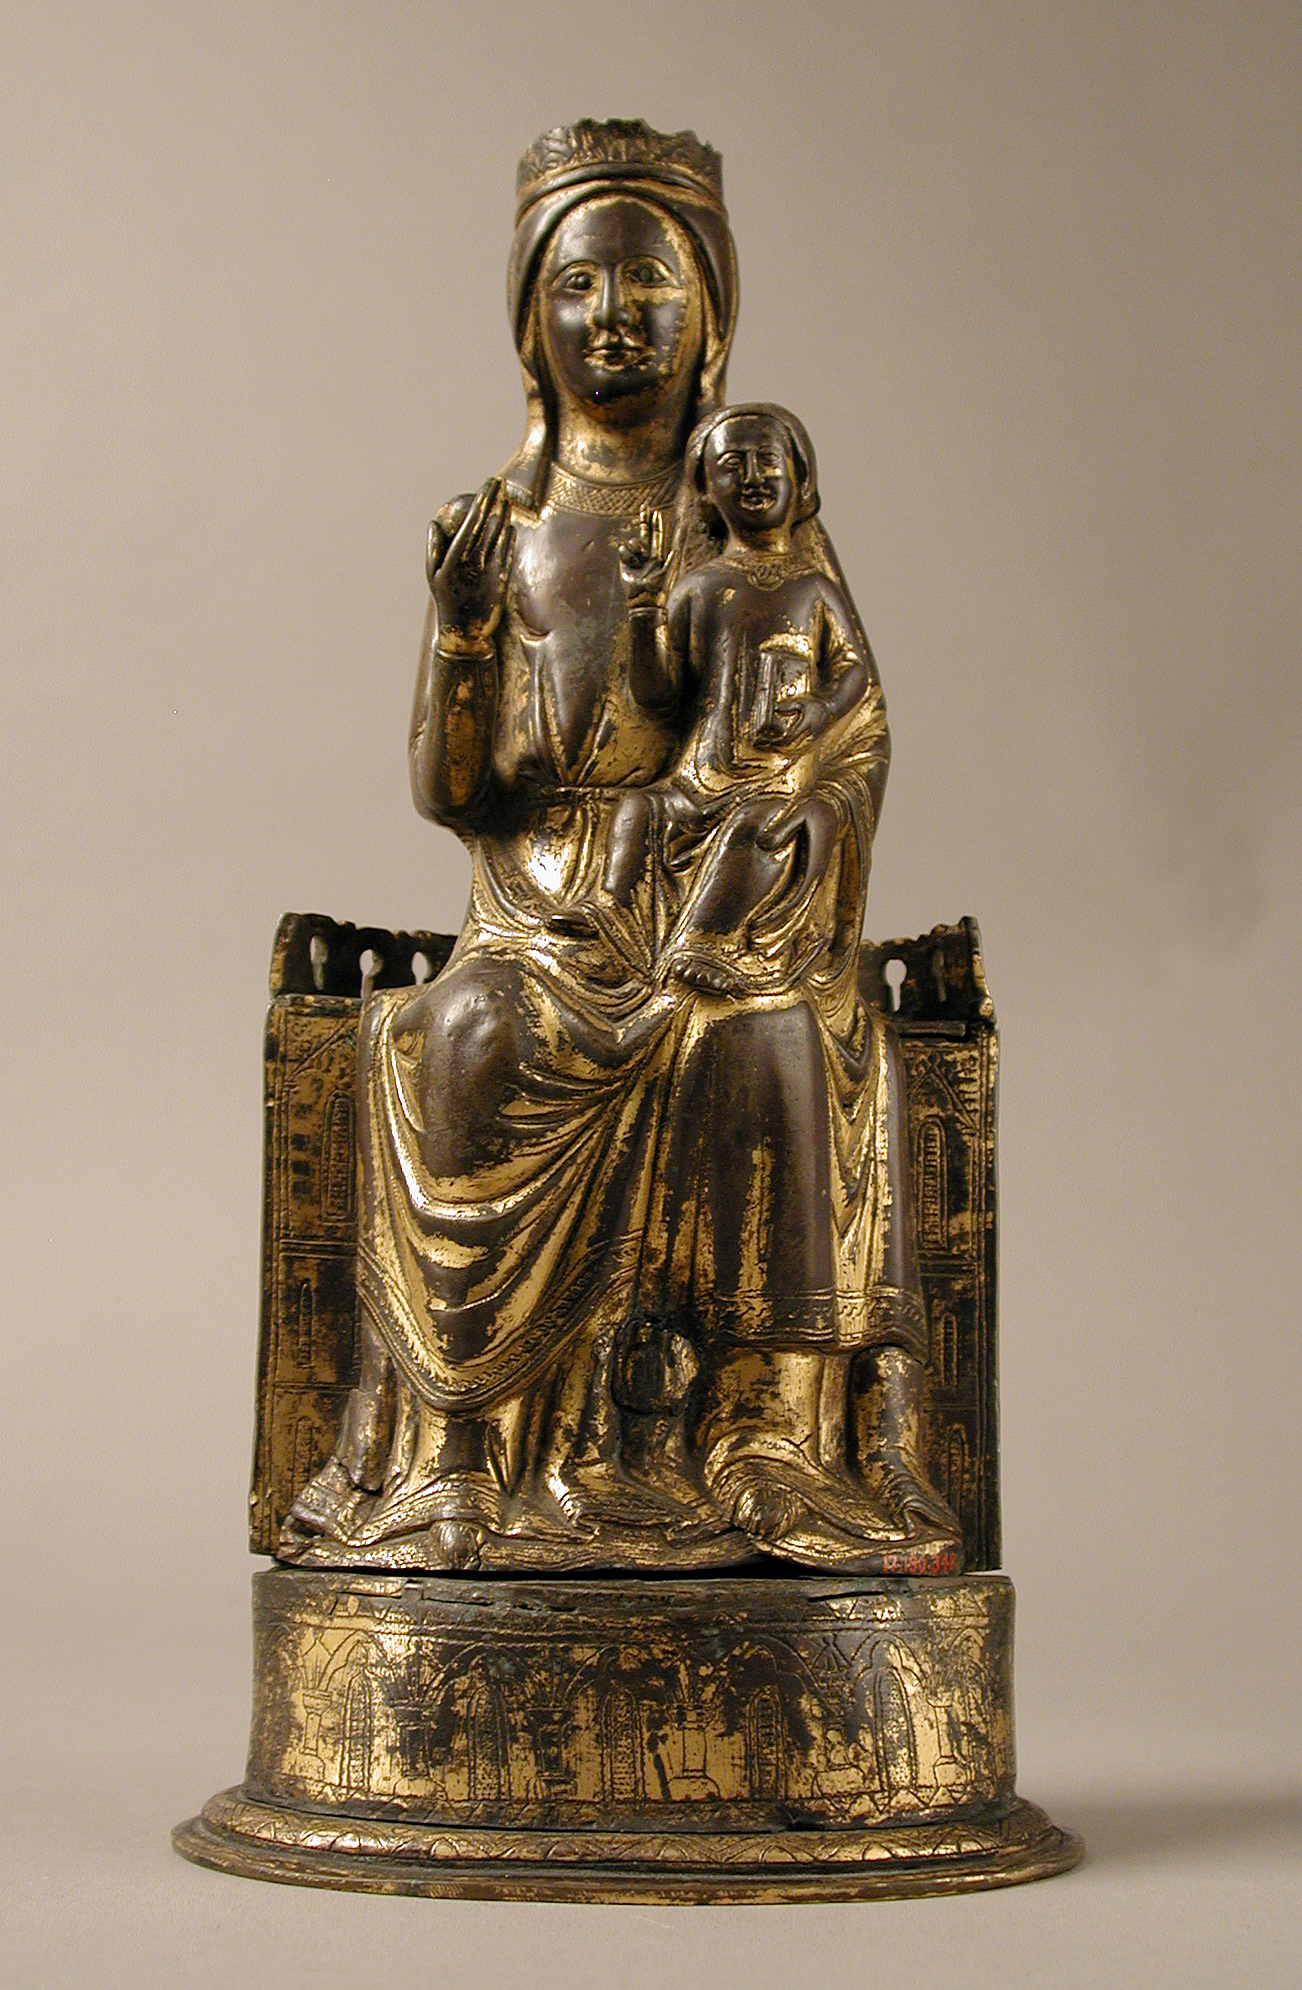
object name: reliquary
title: Virgin and Child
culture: french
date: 1300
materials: gilt copper, enamel, glass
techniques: enamel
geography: france